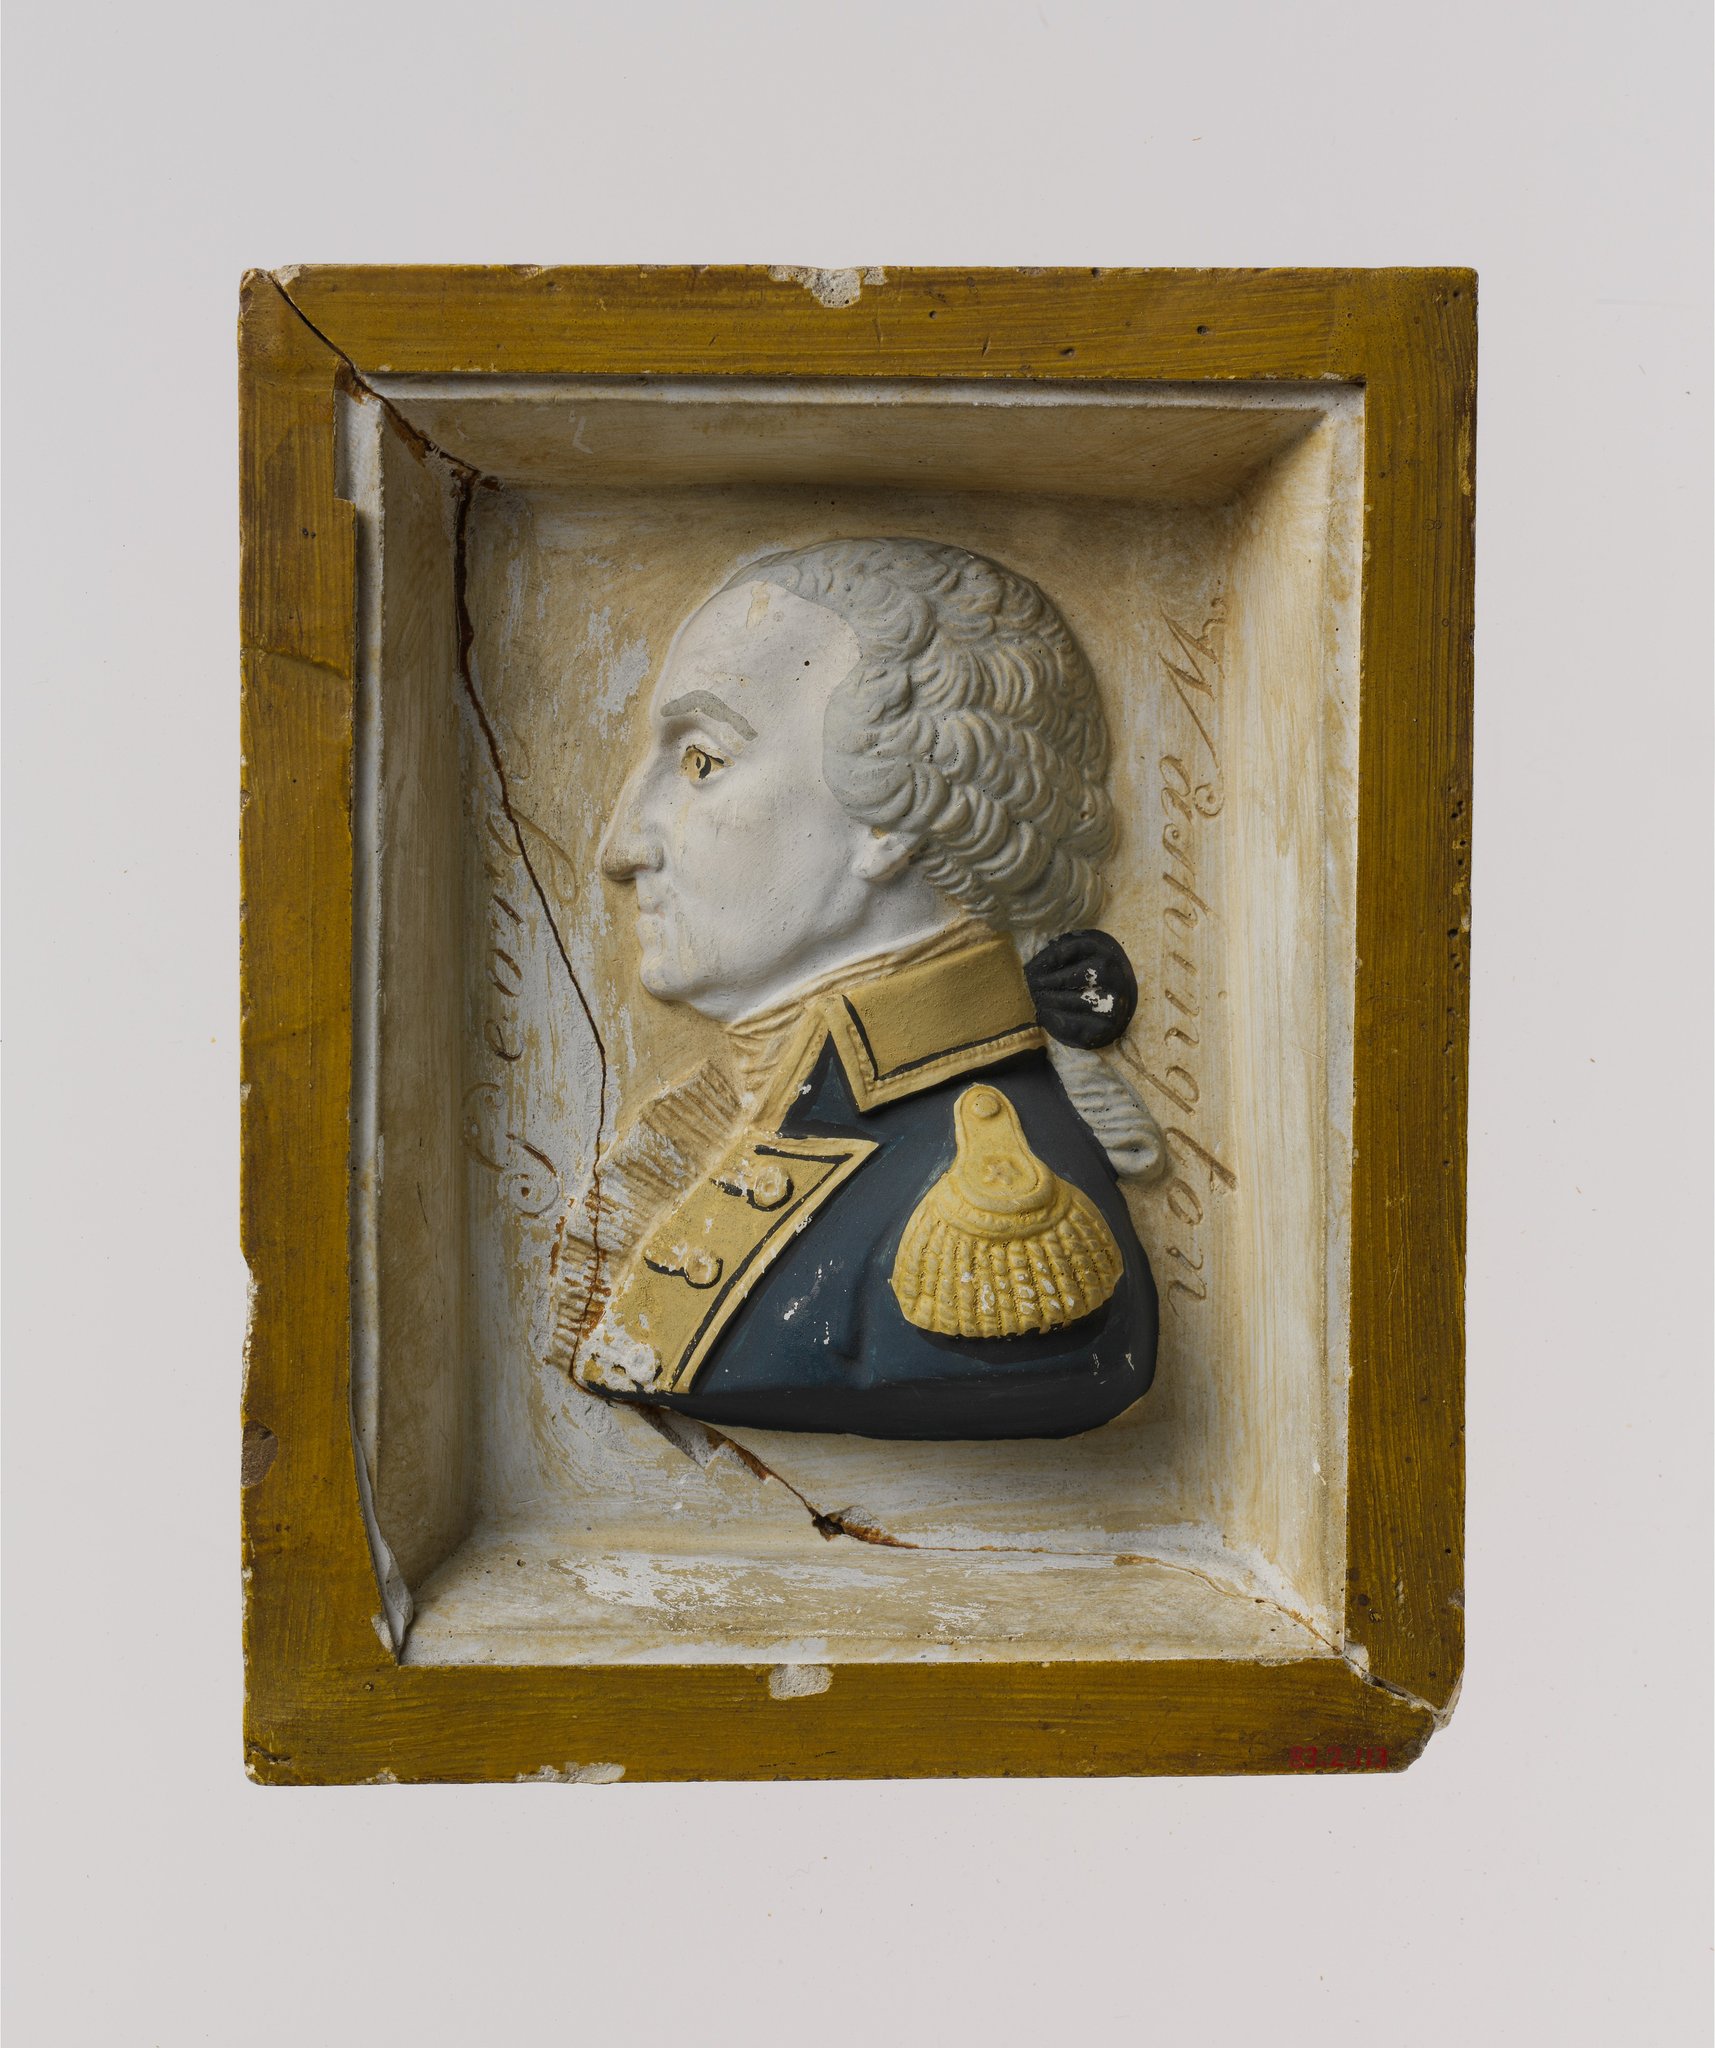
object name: bust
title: George Washington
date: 1800-1830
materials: plaster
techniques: painting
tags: george washington,men,portraits,profiles